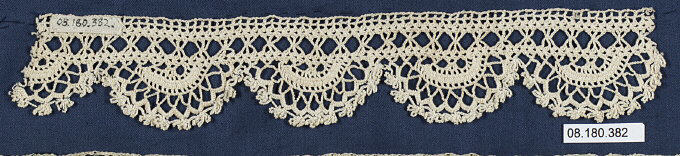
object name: fragment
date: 1801-1900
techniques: crochet